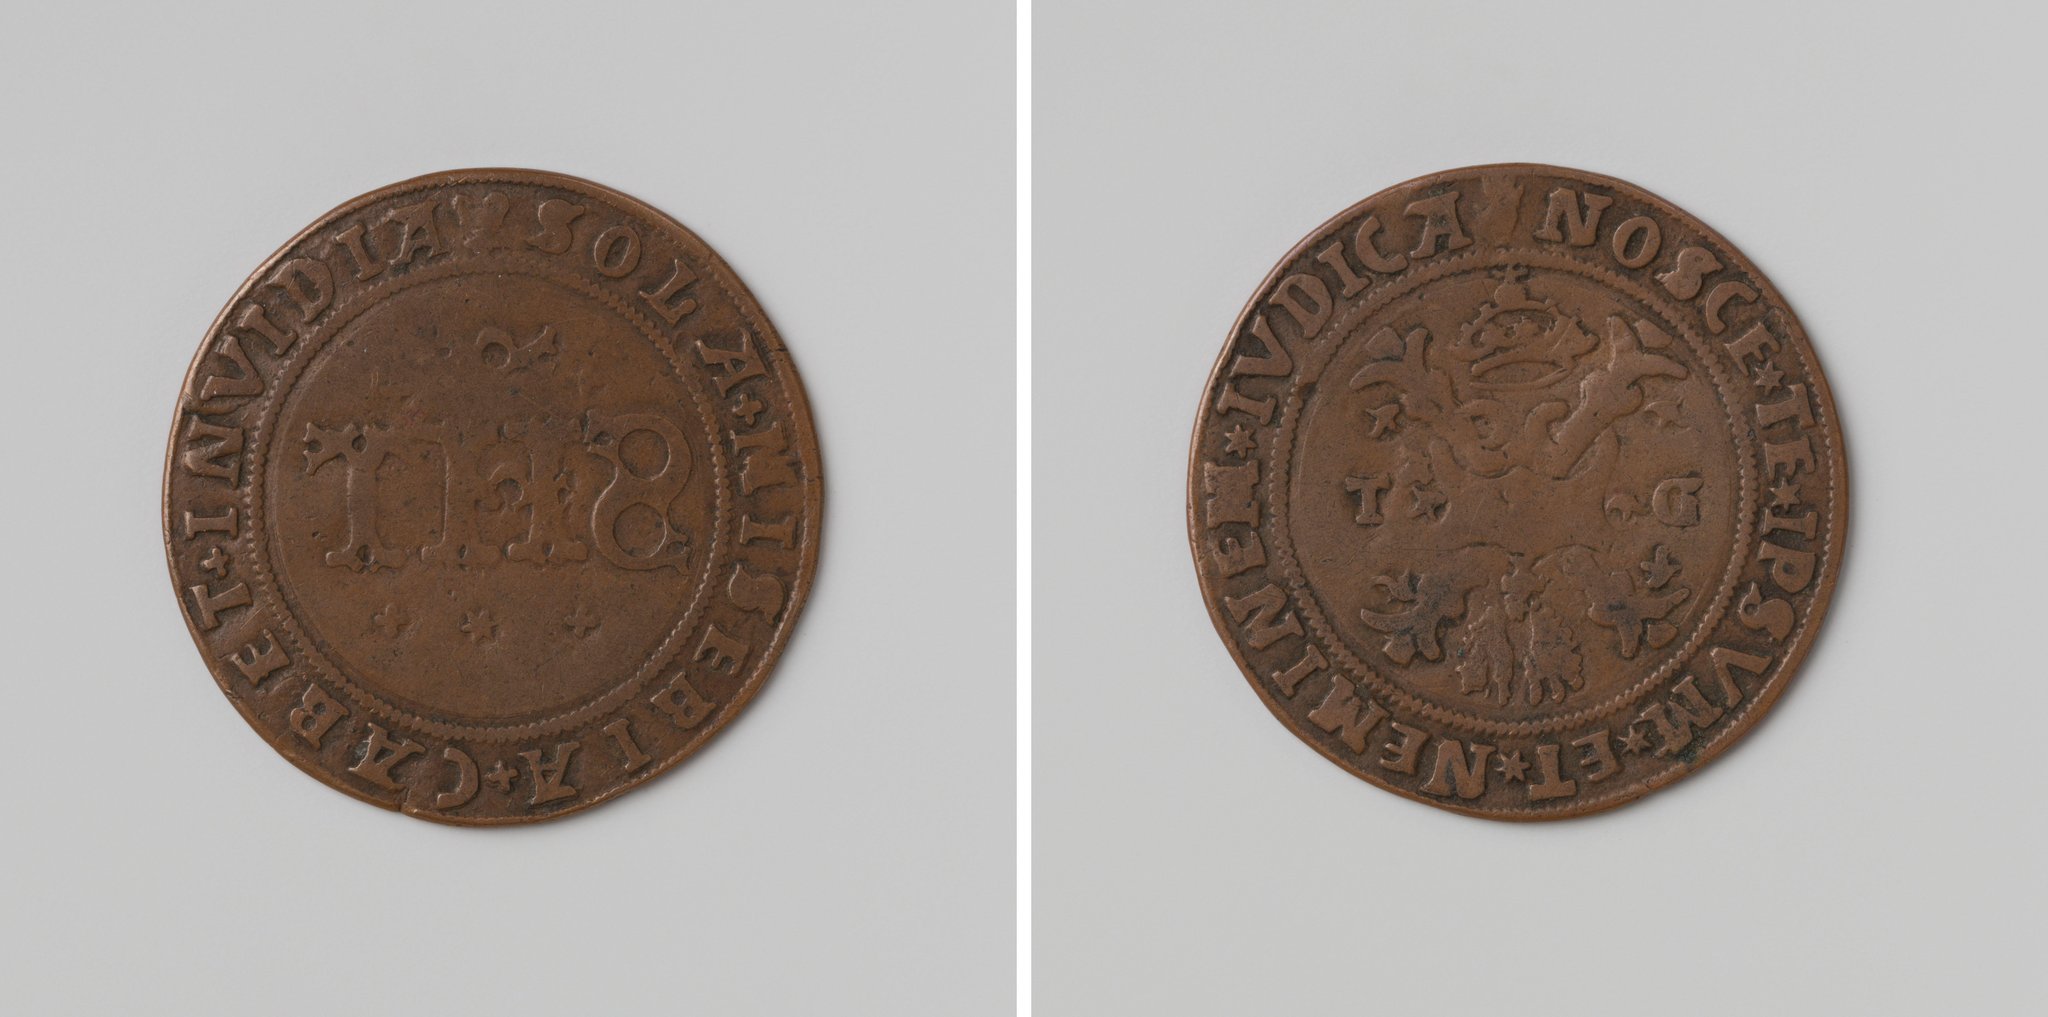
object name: jeton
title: Overlijden van Filips de Schone, hertog van Bourgondie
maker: Anonymous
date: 1506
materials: copper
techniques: striking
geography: antwerp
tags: filips de schone (hertog van bourgondië)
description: Koperen penning. Voorzijde: letters THS onder accolade en twee sterren, boven drie sterren binnen omschrift. Keerzijde: vuurslag, waaraan Gulden Vlies hangt, op Bourgondisch kruis; daarboven: kroon, links: letter T, rechts: letter G binnen omschrift